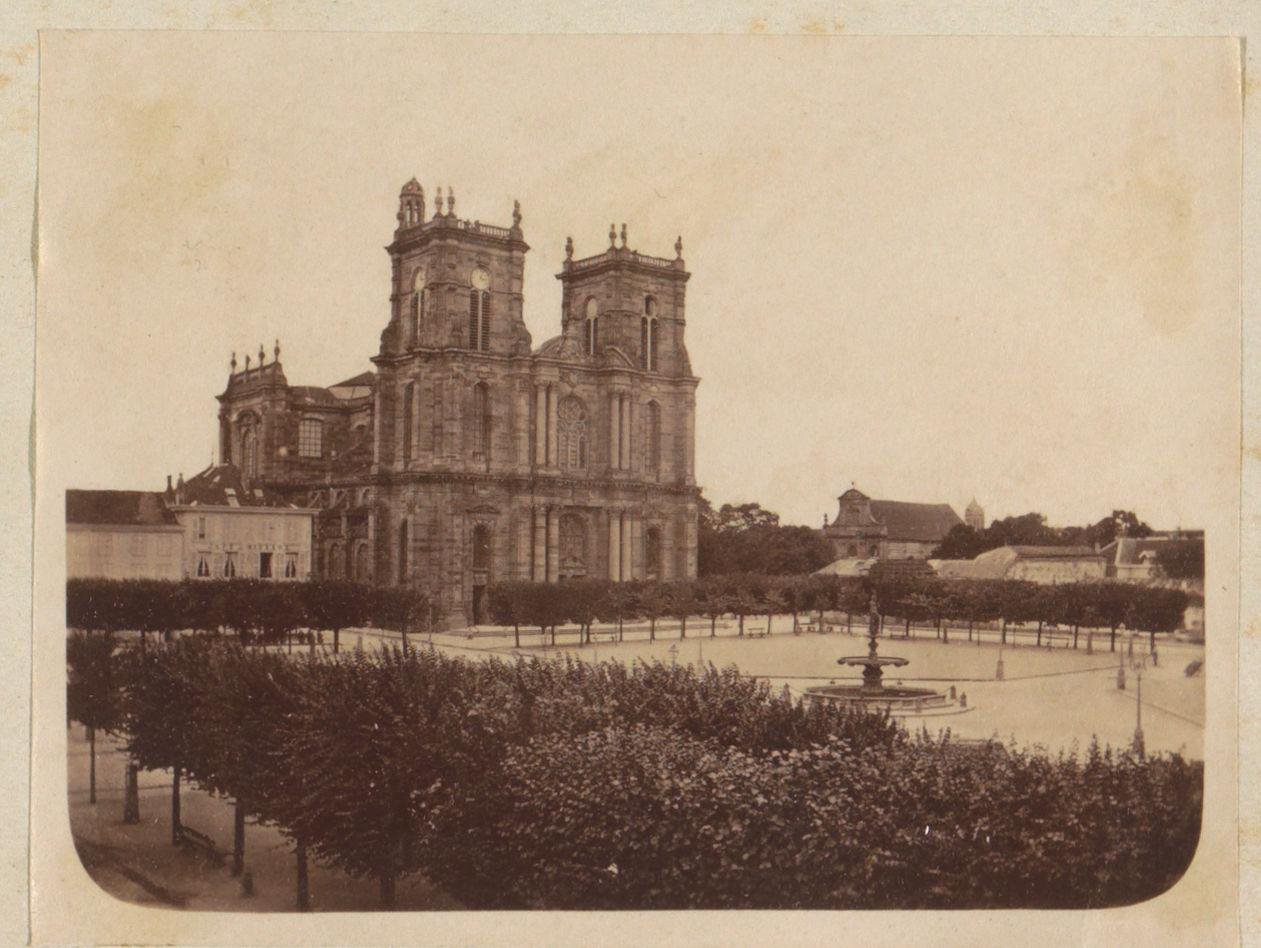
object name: photograph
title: Gezicht op een plein met een kerk en fontein, vermoedelijk in Frankrijk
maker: Anonymous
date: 1883-1886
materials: photographic support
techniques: albumen print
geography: france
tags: church (exterior), square, place, circus, etc. (+ city(-scape) with figures, staffage), france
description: Onderdeel van Album van een Franse amateurfotograaf met opnames van familie, militairen, industrie, landschappen en bezienswaardigheden in Frankrijk.